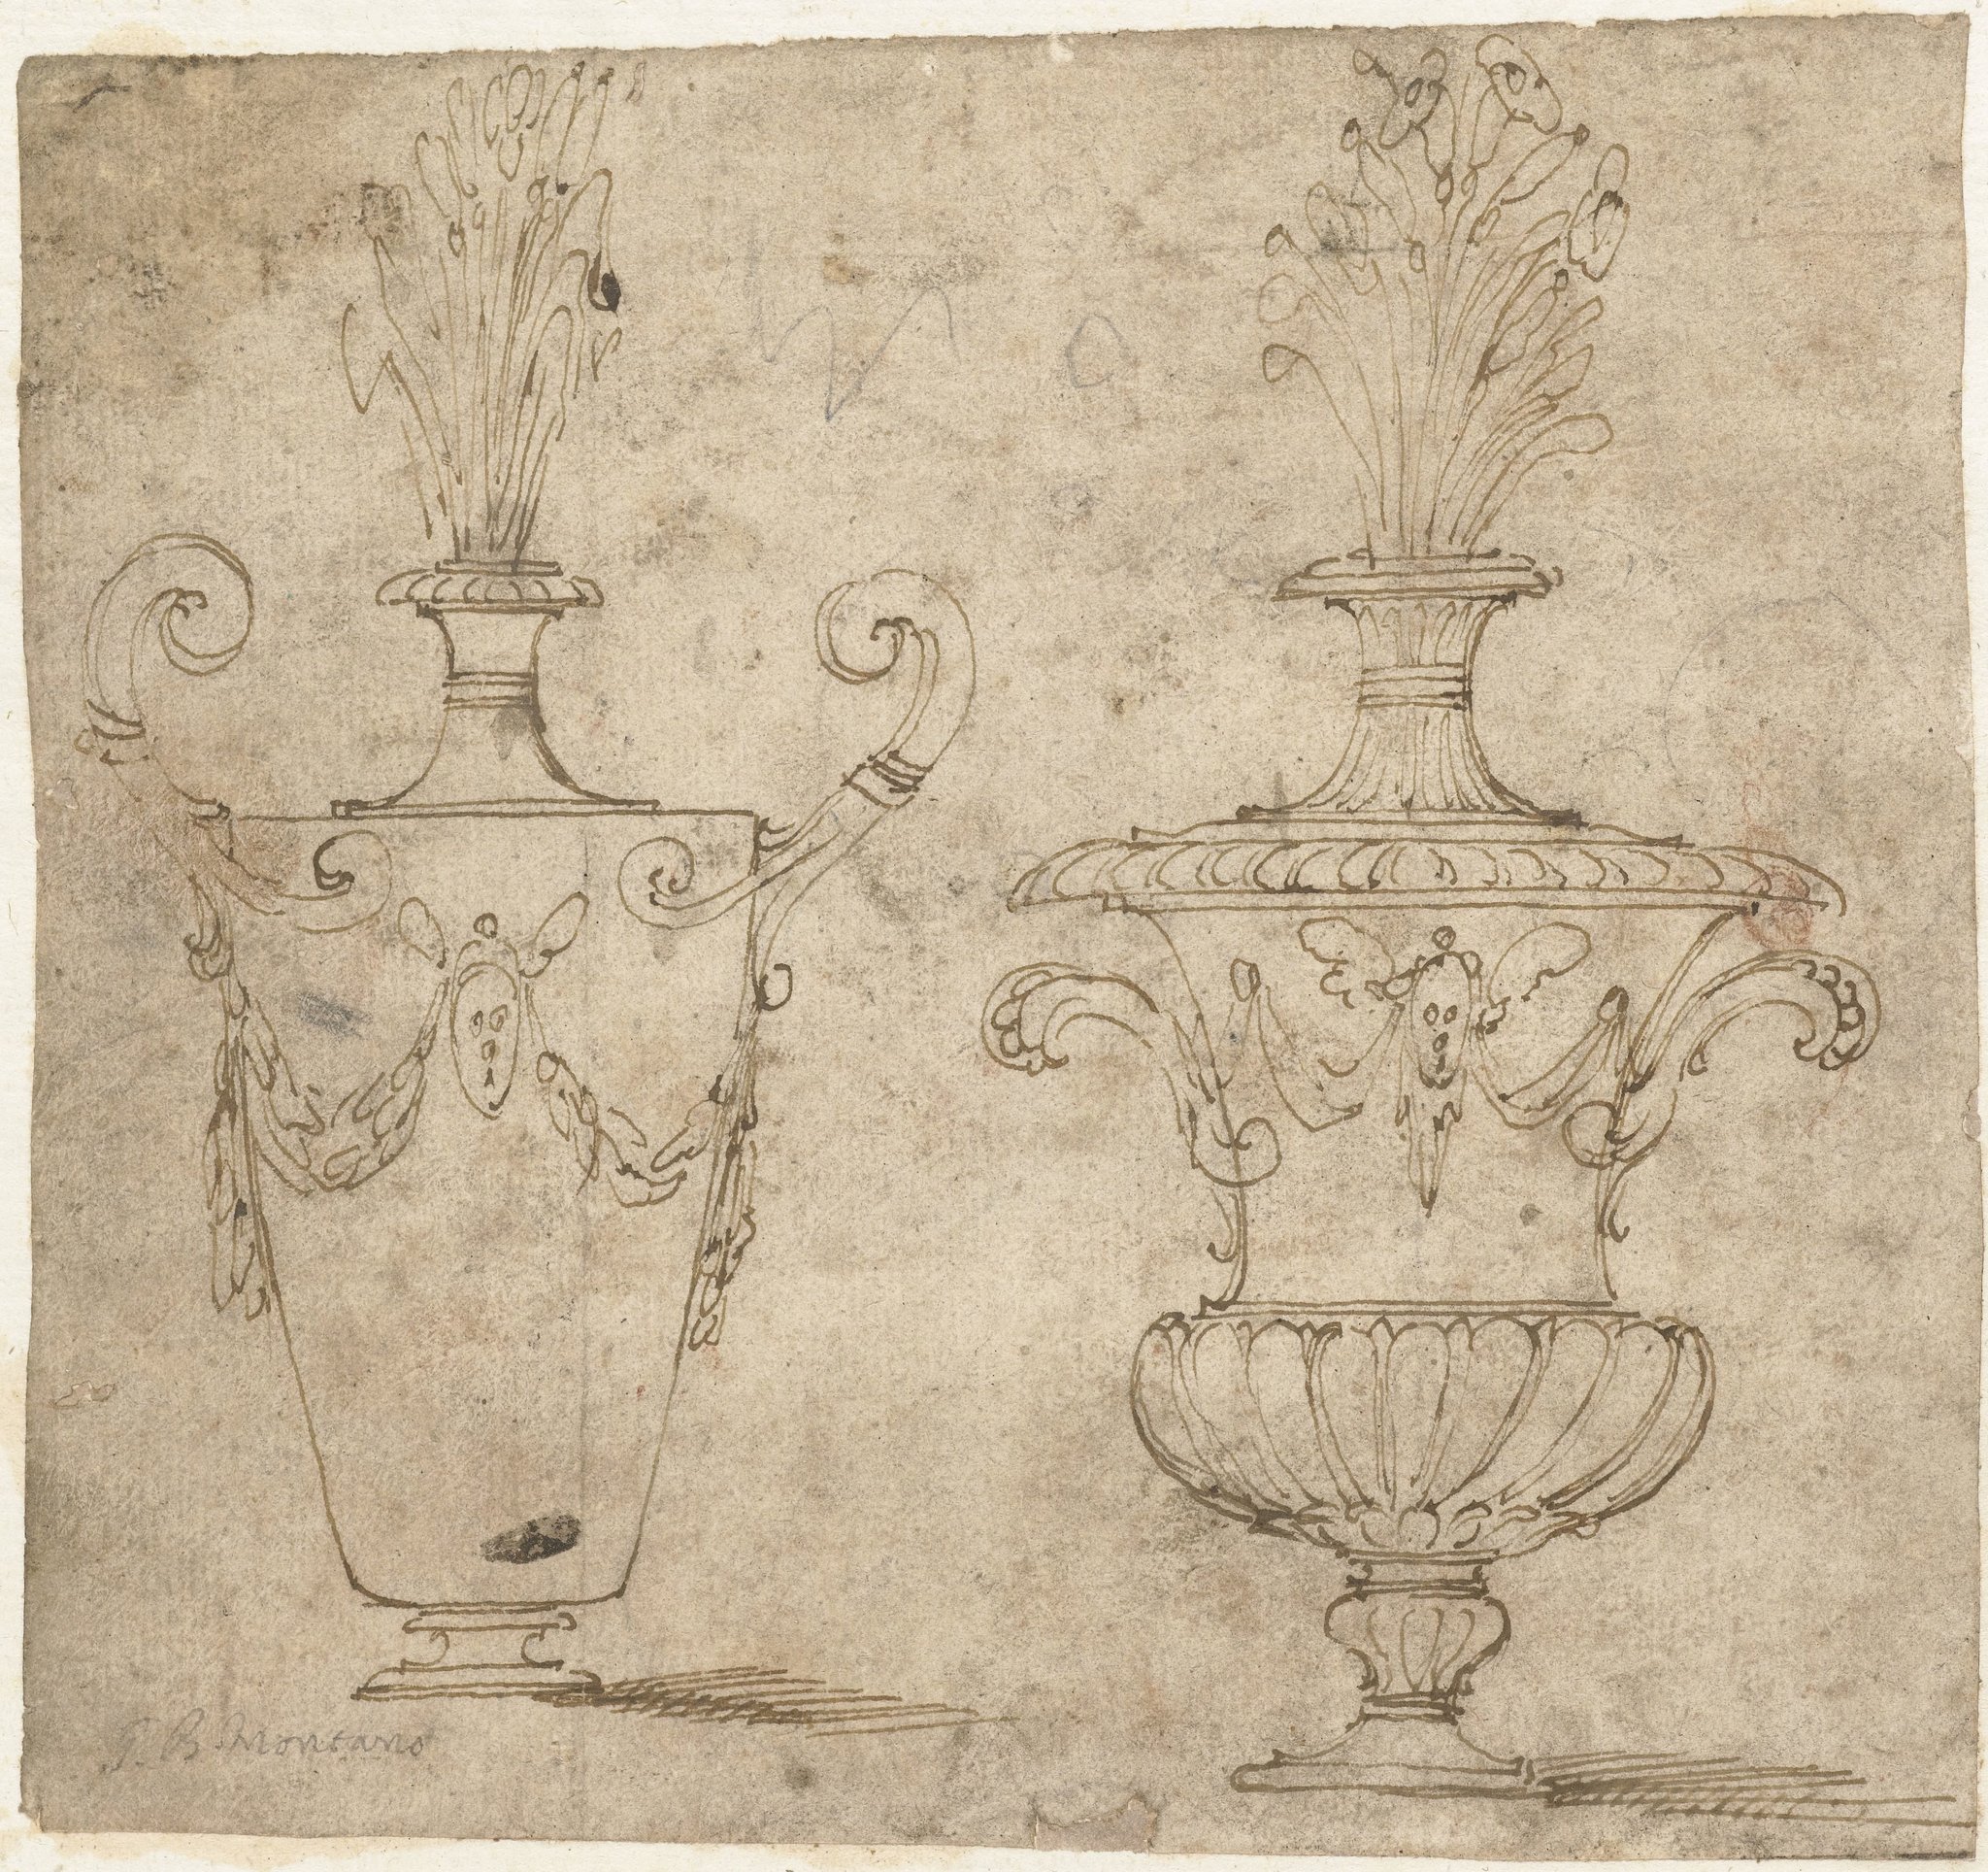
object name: drawing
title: Twee schetsen van siervazen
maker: giovanni battista montano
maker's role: draughtsman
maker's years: 1534-1621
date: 1544-1621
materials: ink, paper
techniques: pen